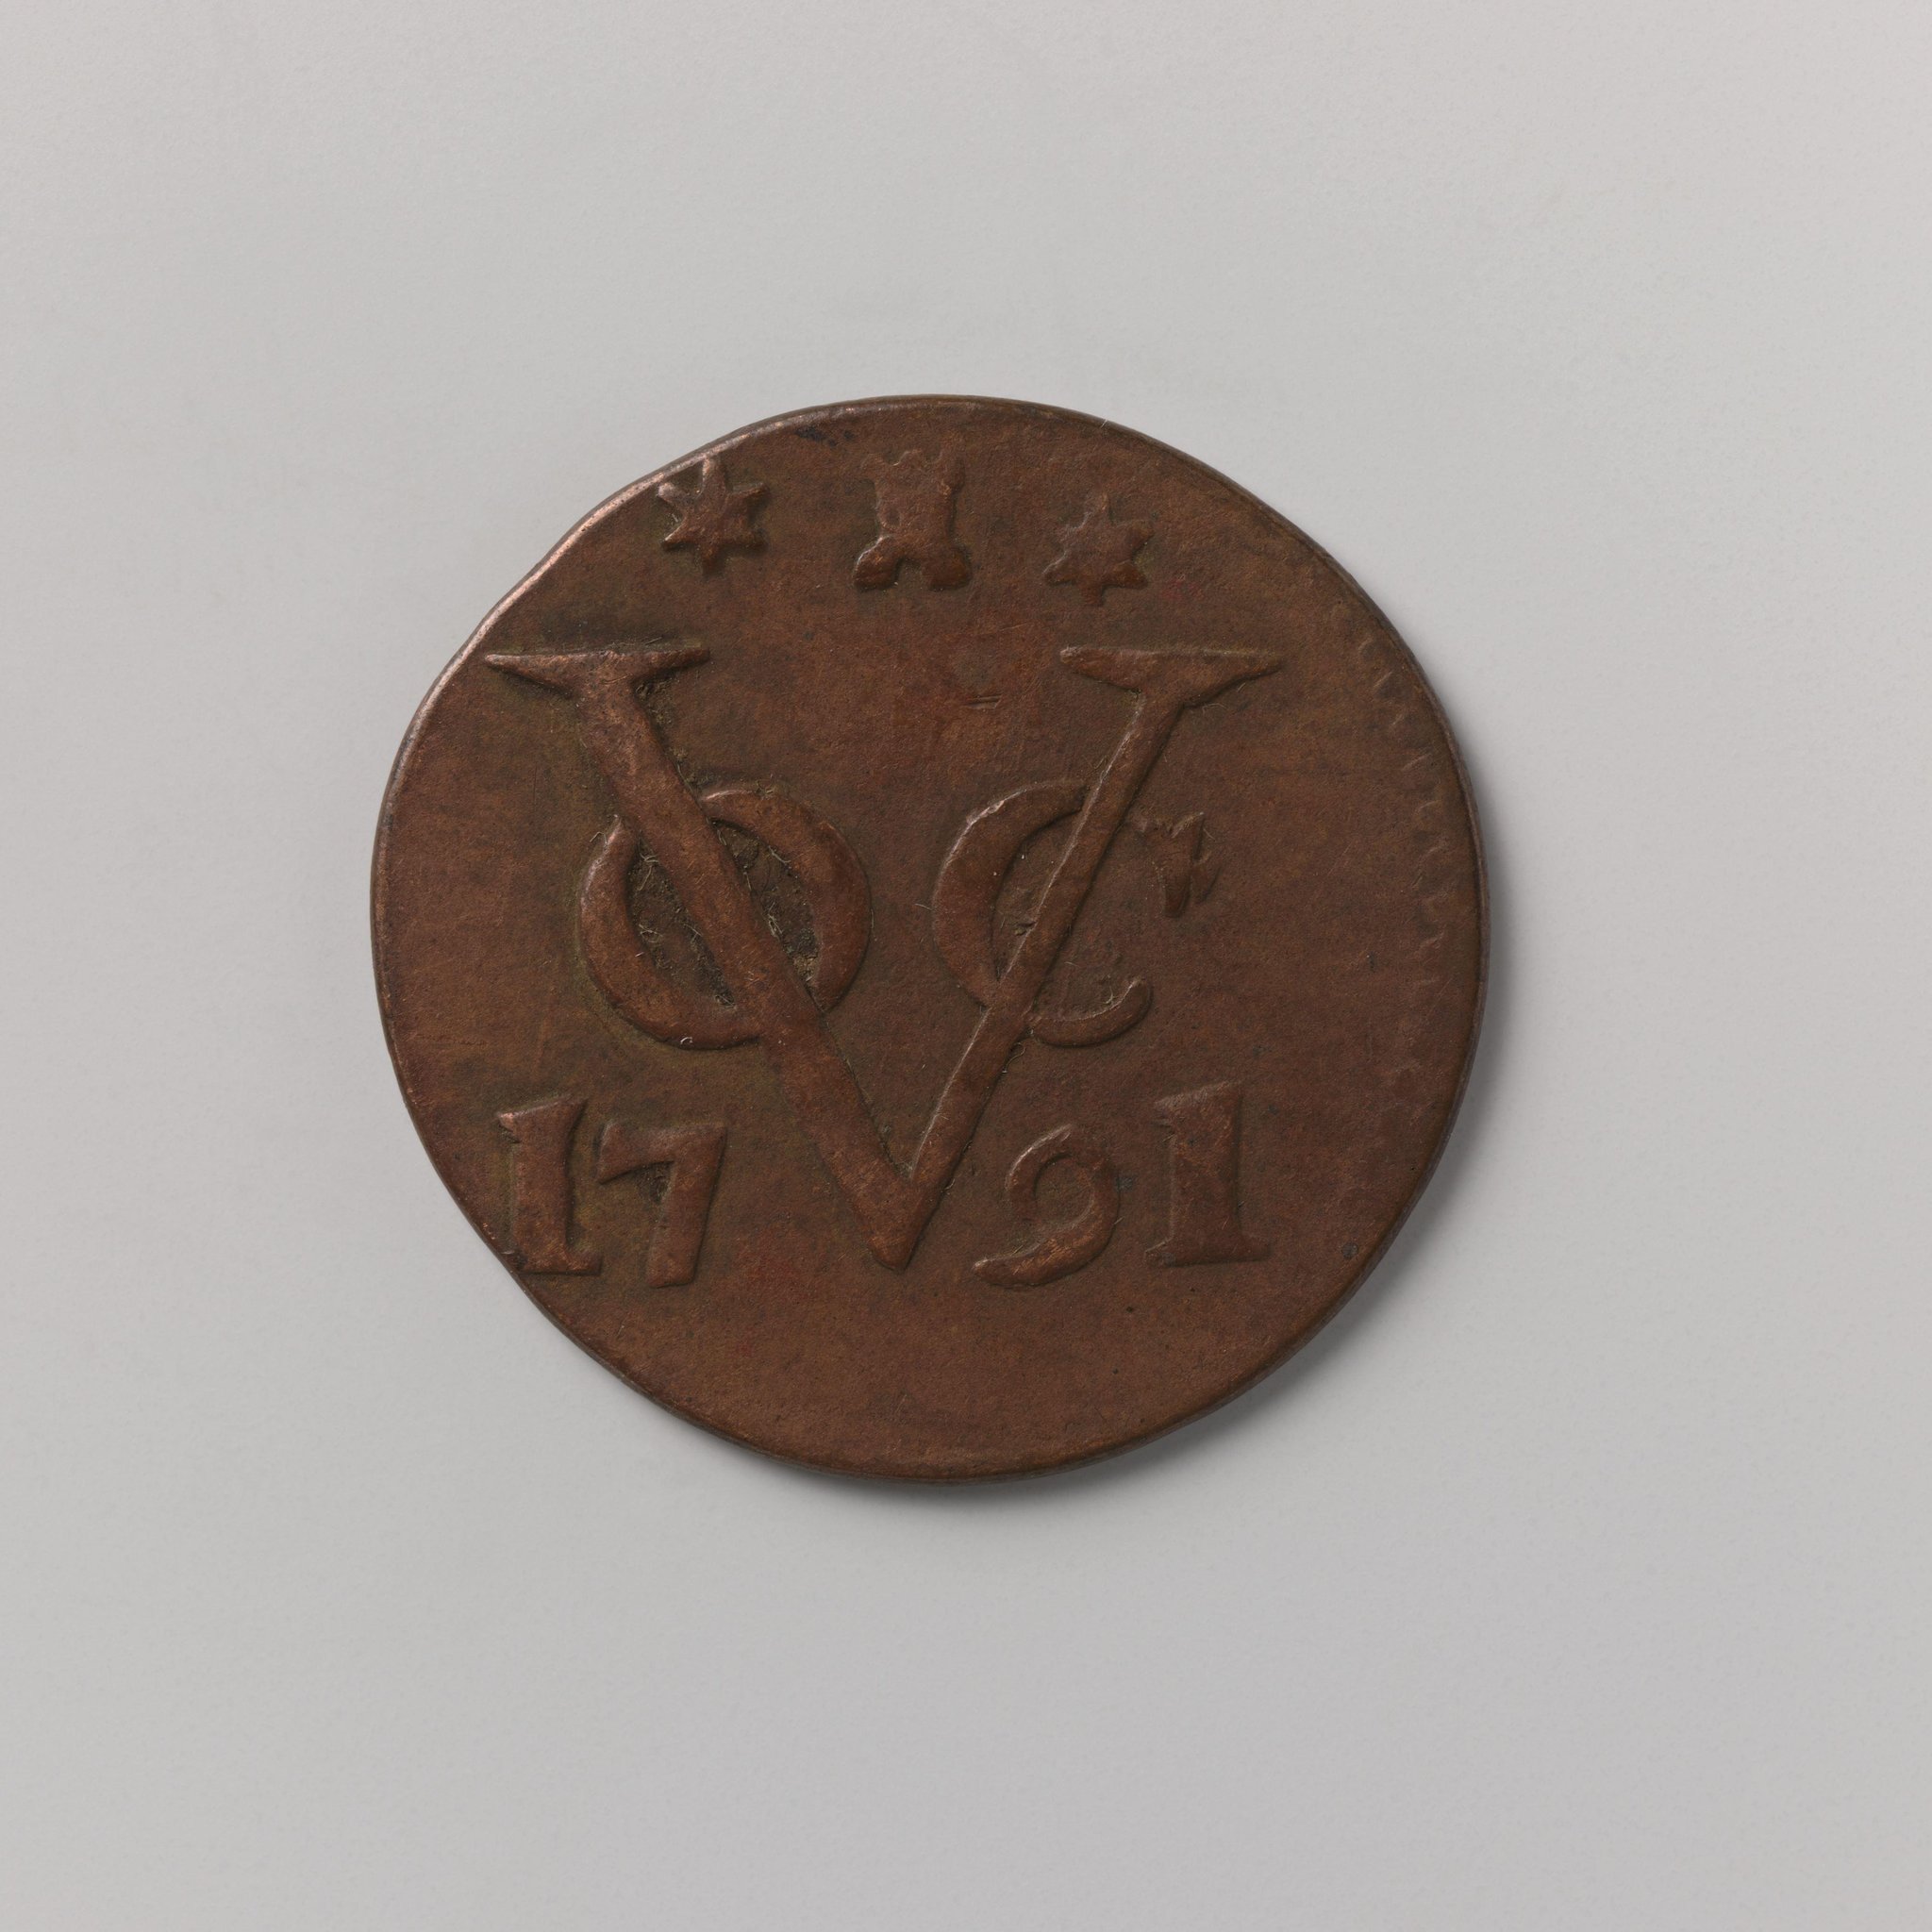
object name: coin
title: VOC, duit Zeeland, 1791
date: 1791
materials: copper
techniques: striking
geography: middelburg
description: Koperen munt. Voorzijde: gekroond wapenschild van Zeeland. Keerzijde: monogram van de VOC, waarboven muntteken en waaronder jaartal. Gladde rand.